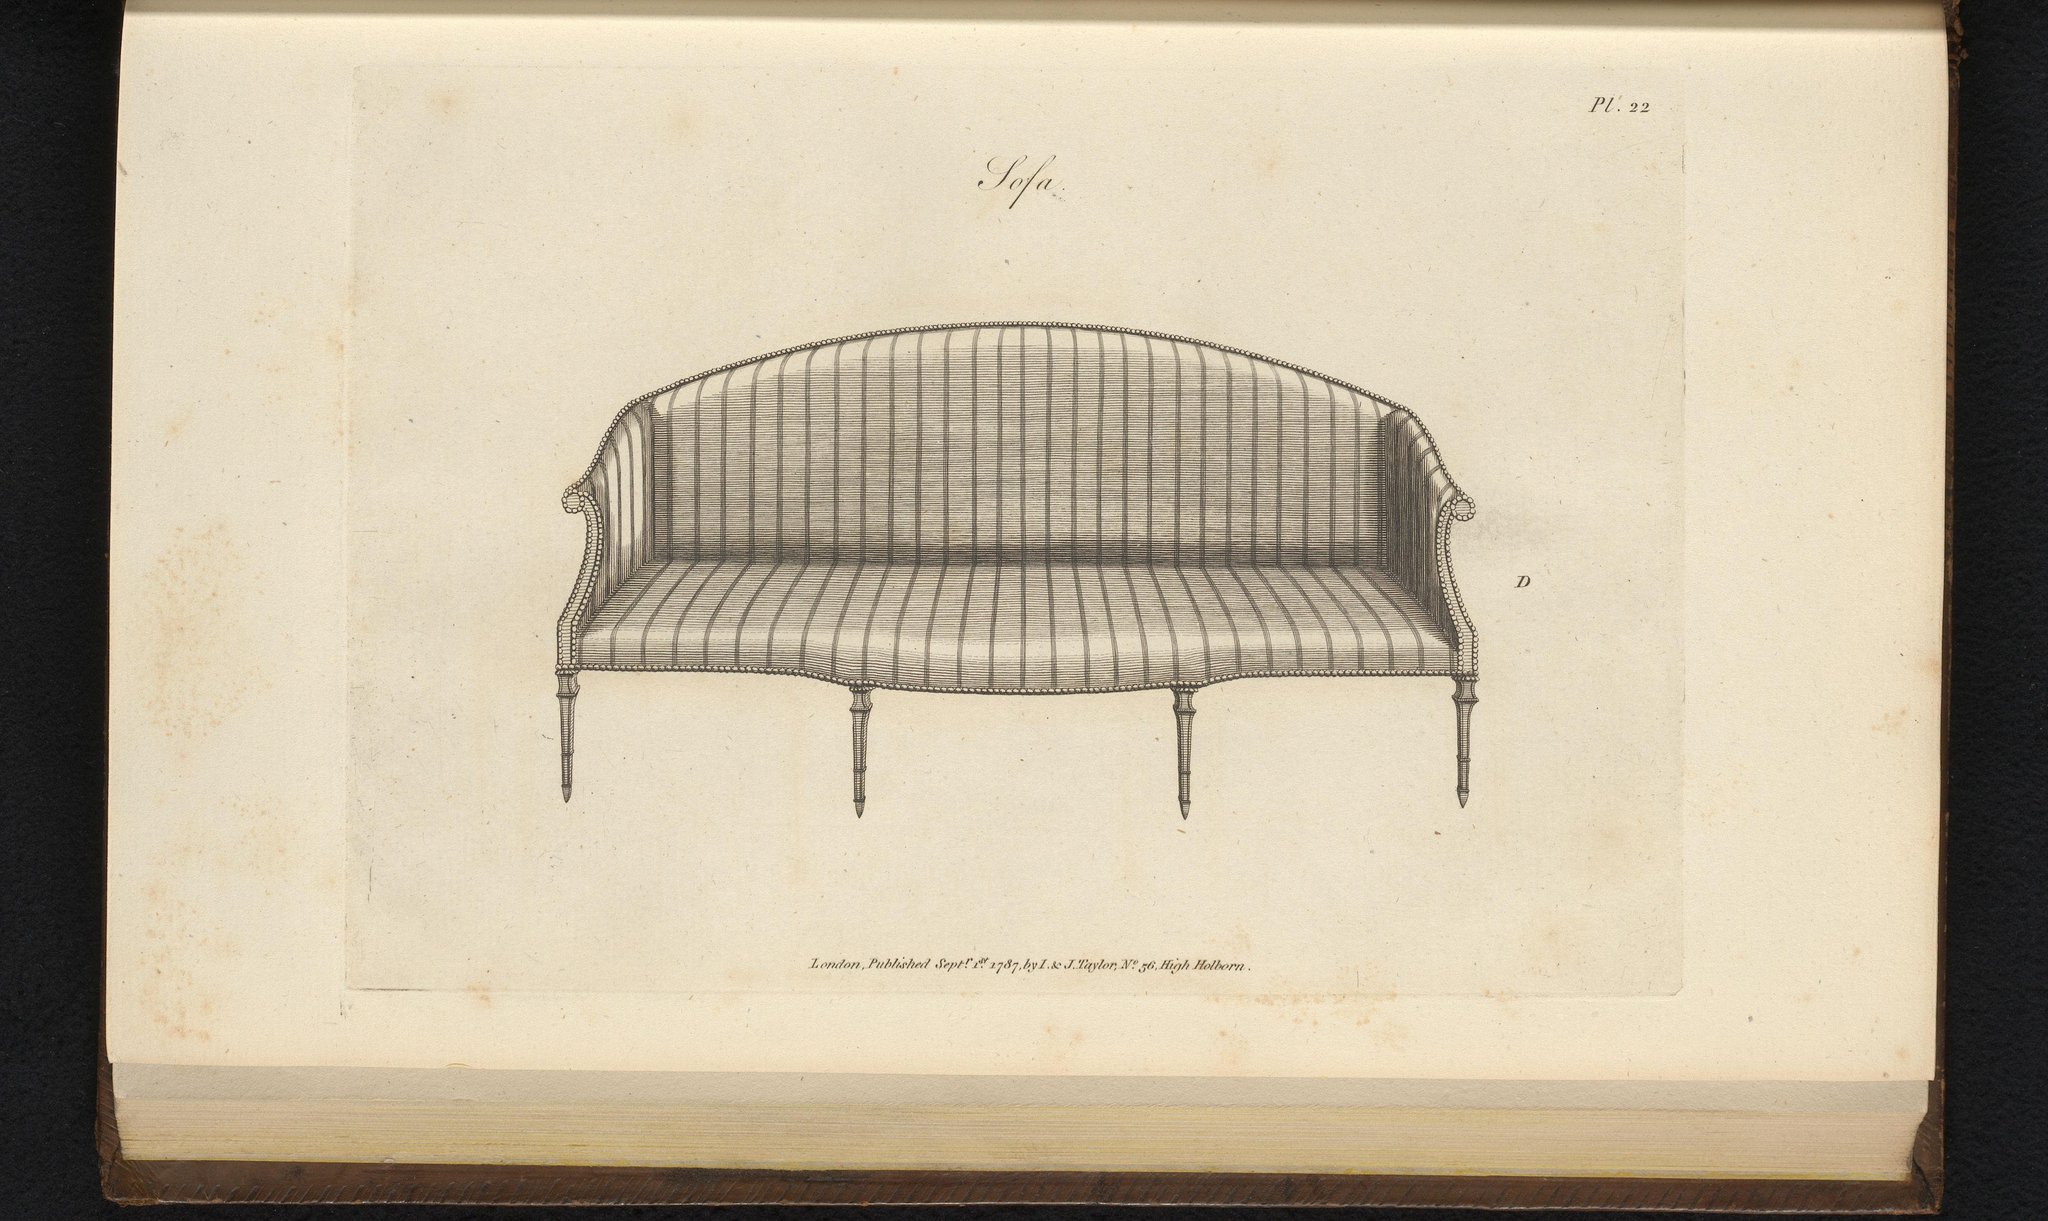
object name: page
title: Sofa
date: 1787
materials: paper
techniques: engraving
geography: holborn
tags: couch, sofa, settee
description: Genummerd: Pl. 22. Bank gemerkt: D. Prent maakt deel uit van een boek.